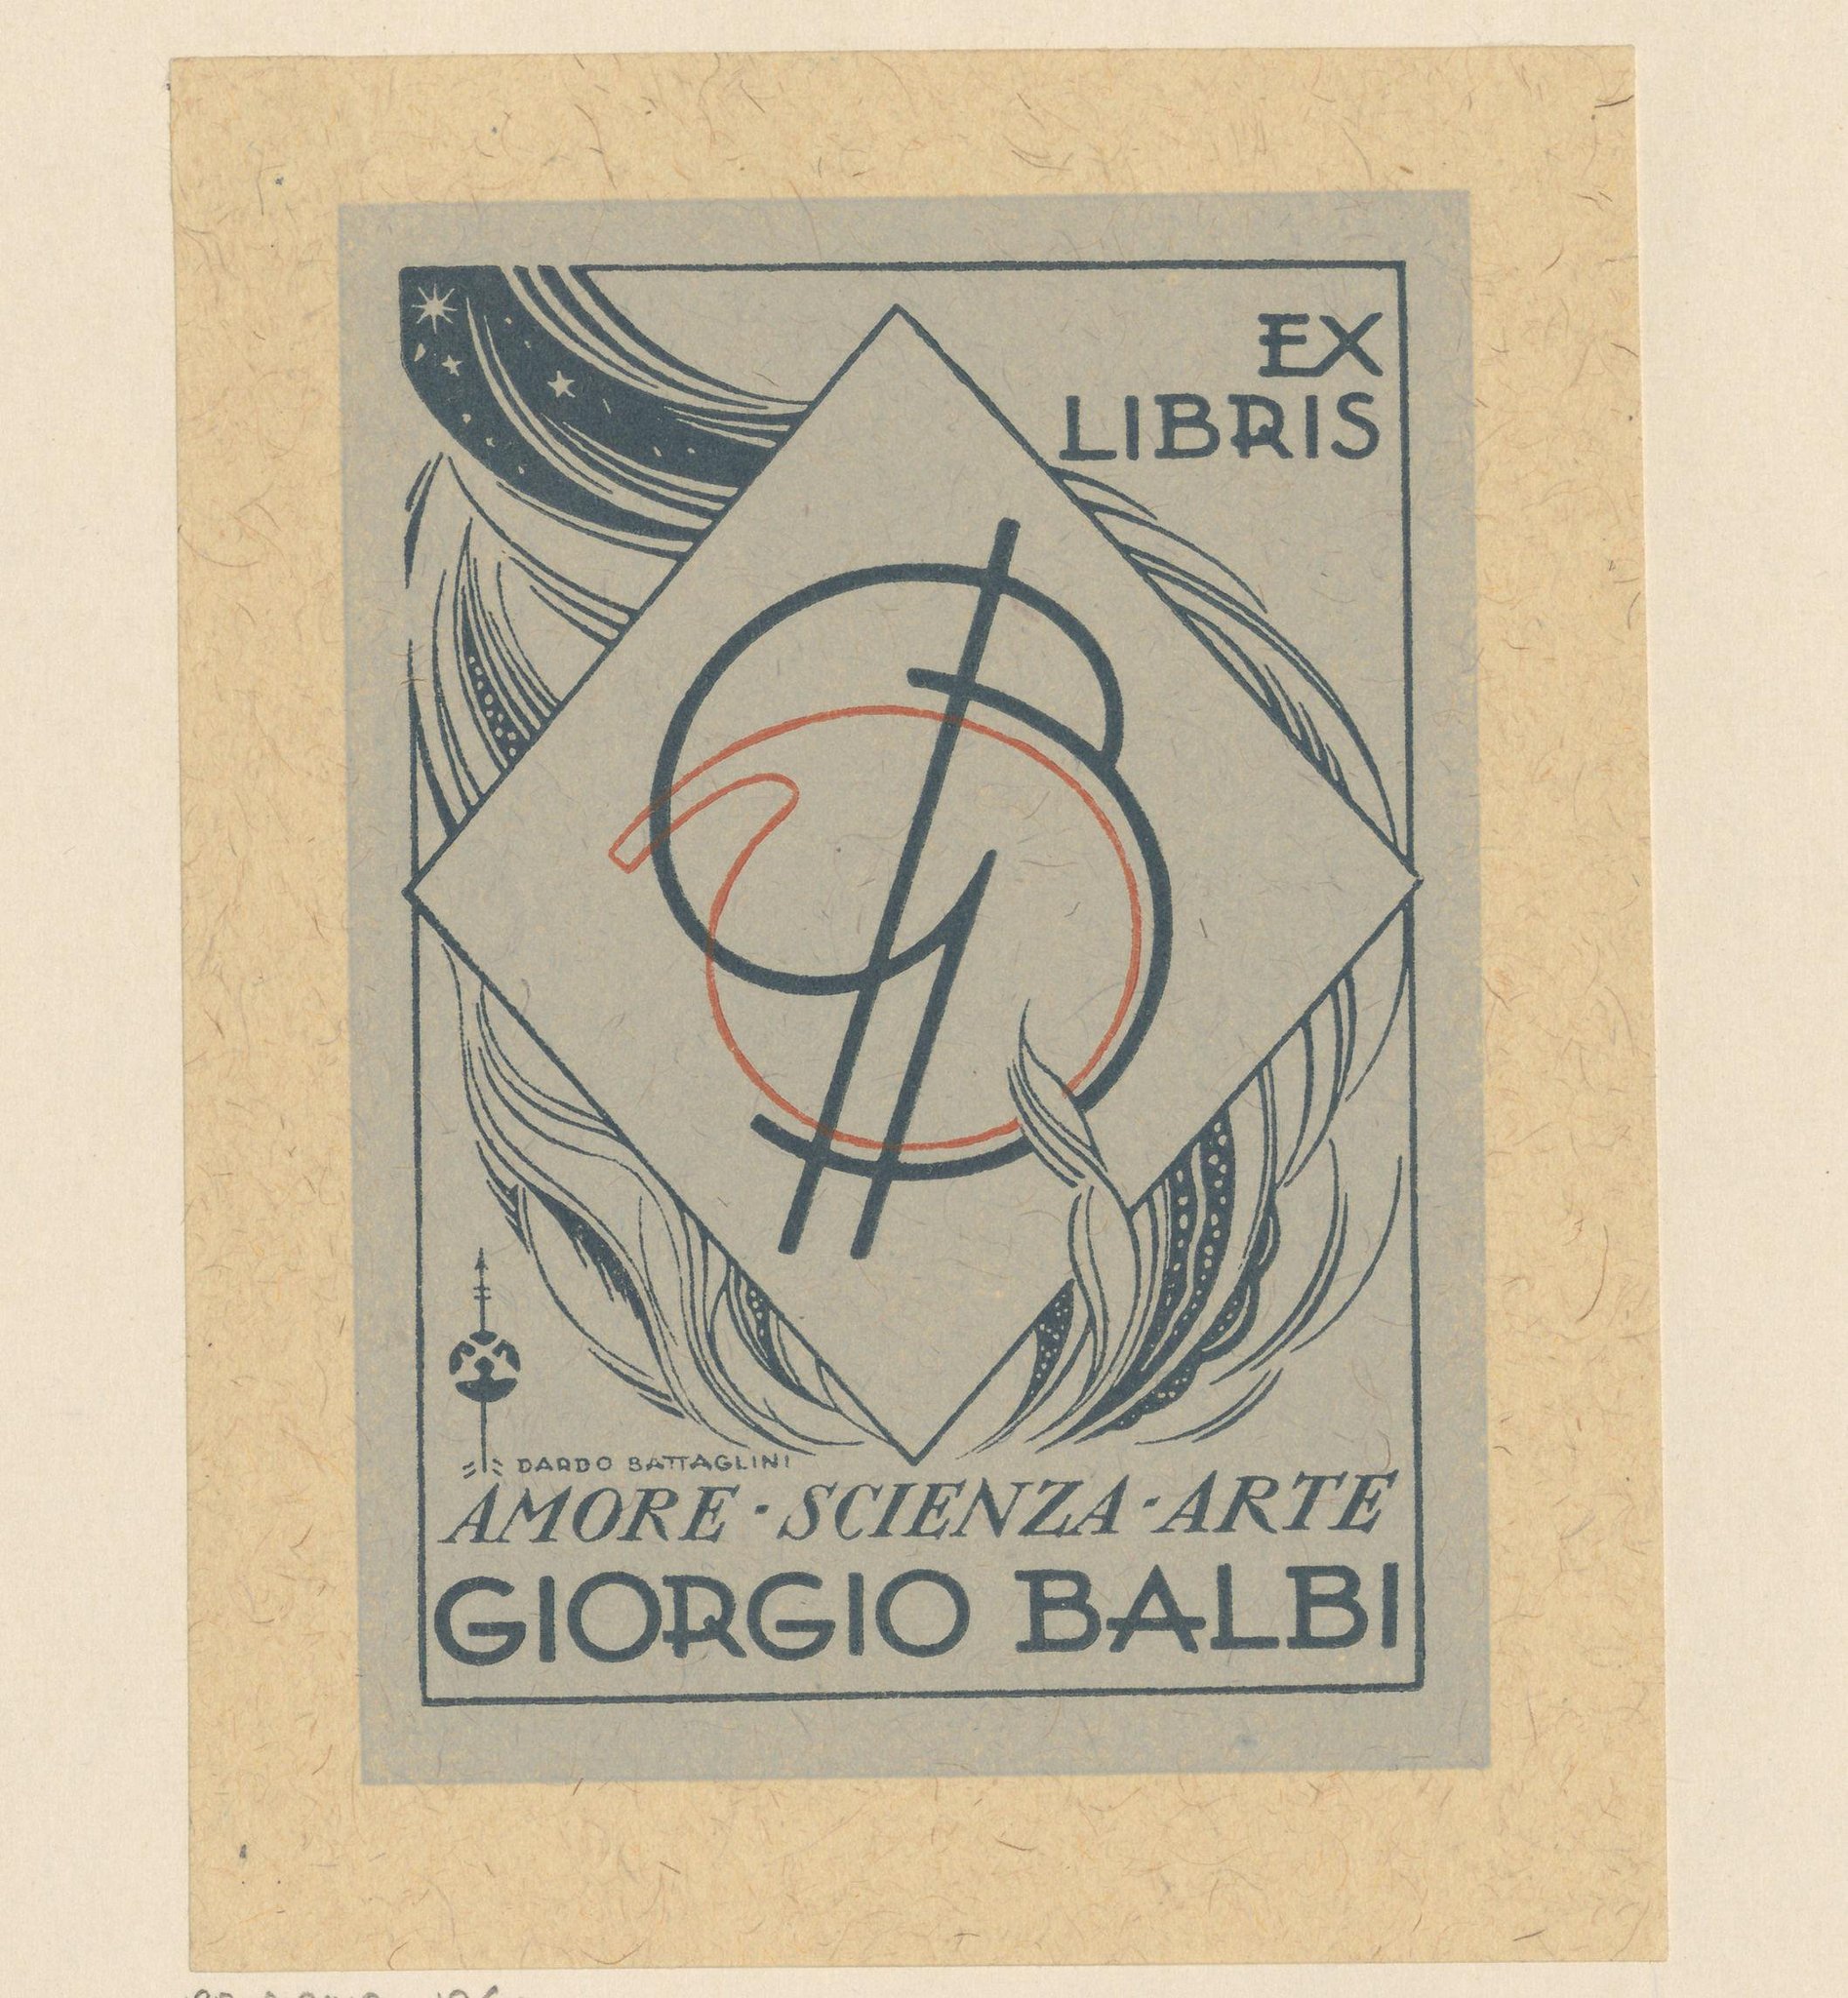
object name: bookplate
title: Amore, scienza, srte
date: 1899-1953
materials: paper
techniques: planographic printing, printing block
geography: italy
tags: additional stages: distillation (destillatio), stars, flame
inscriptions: inscription: ‘Dardo Battaglini / 1944’